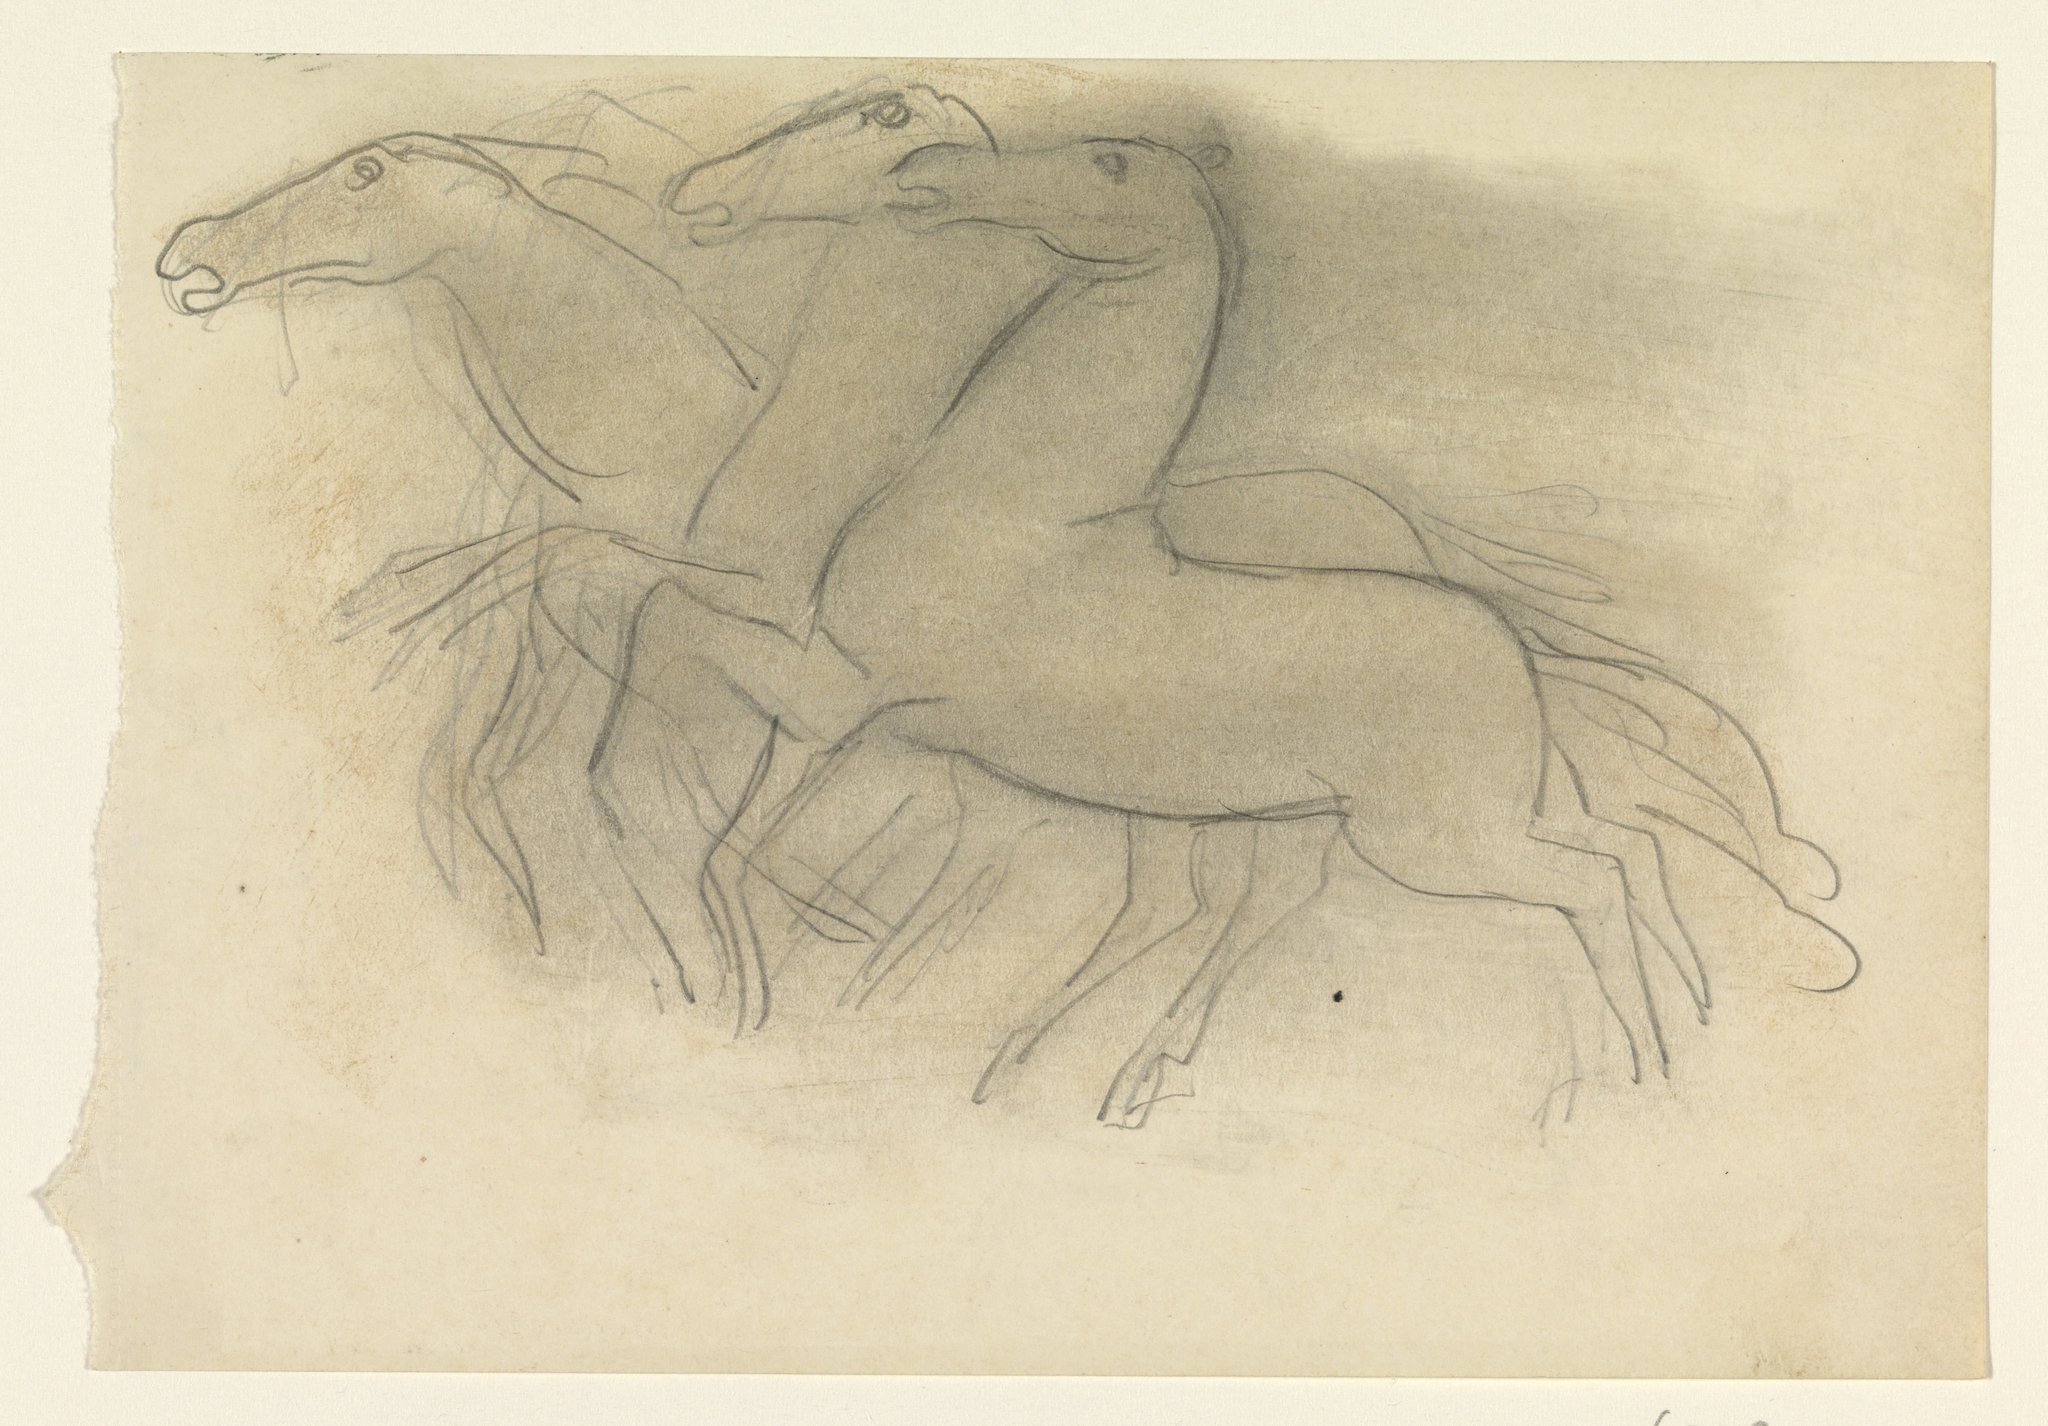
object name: drawing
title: Rennende paarden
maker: leo gestel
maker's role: draughtsman, print maker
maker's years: 1881-1941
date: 1891-1941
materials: chalk, paper, pencil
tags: horse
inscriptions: collector's mark: Lugt 2228